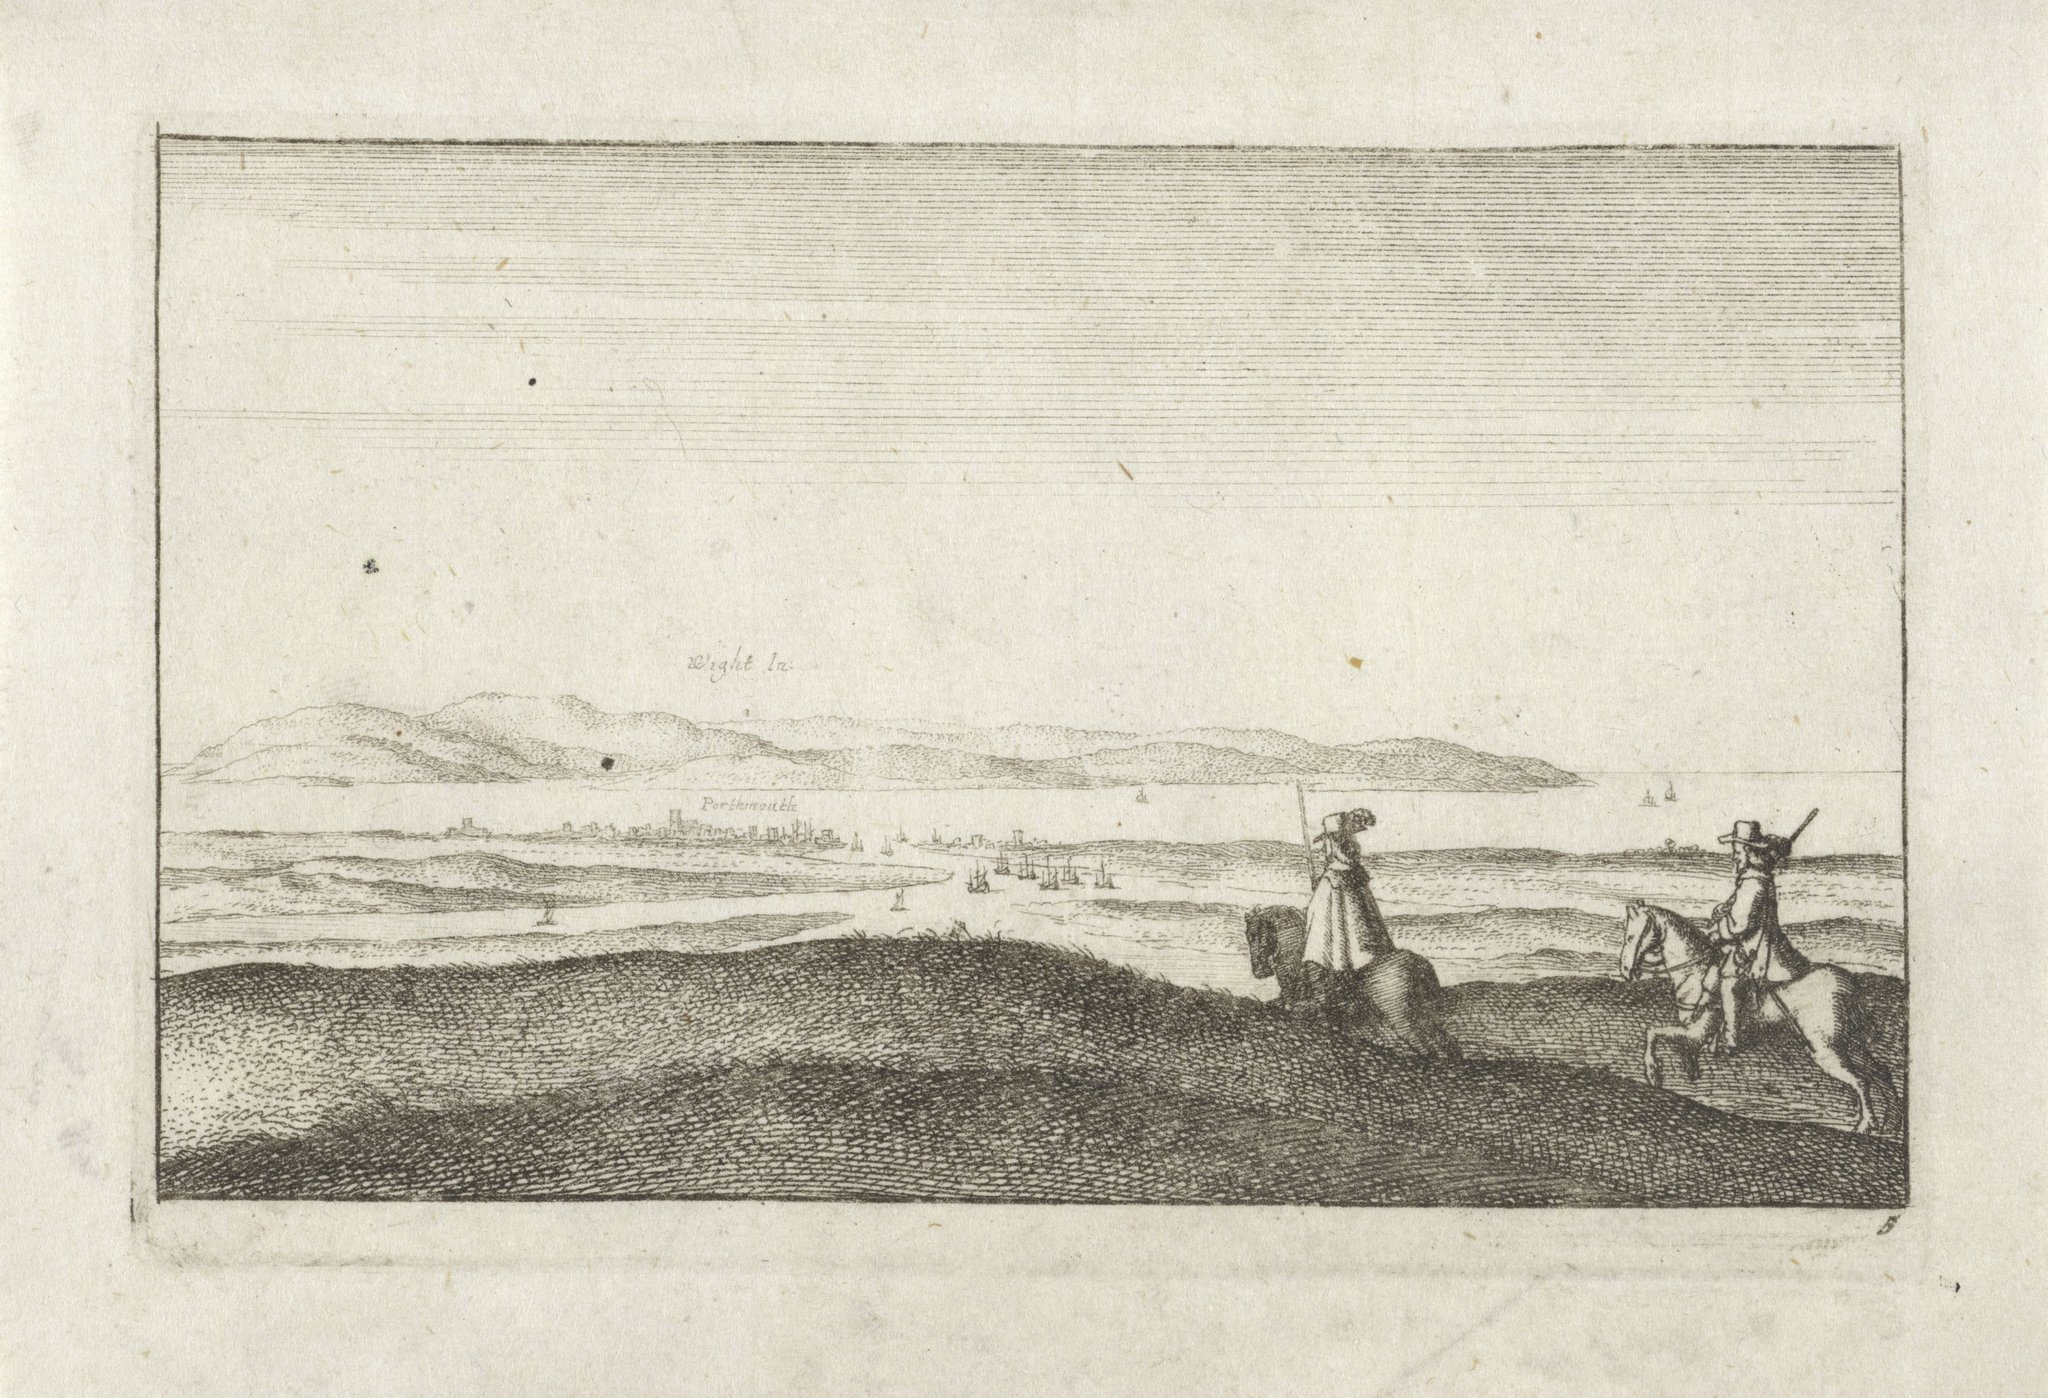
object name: print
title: Landschap met gezicht op het eiland Wight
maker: wenceslaus hollar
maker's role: draughtsman, print maker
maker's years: 1607-1677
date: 1643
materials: paper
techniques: drypoint, etching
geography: london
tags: landscapes with waters, waterscapes, seascapes (in the temperate zone), island (+ landscape with figures, staffage)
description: Prent maakt mogelijk deel uit van de serie "Prospectus aliquot locorum in diversis Provincijs iacentium", NHG 454-63.